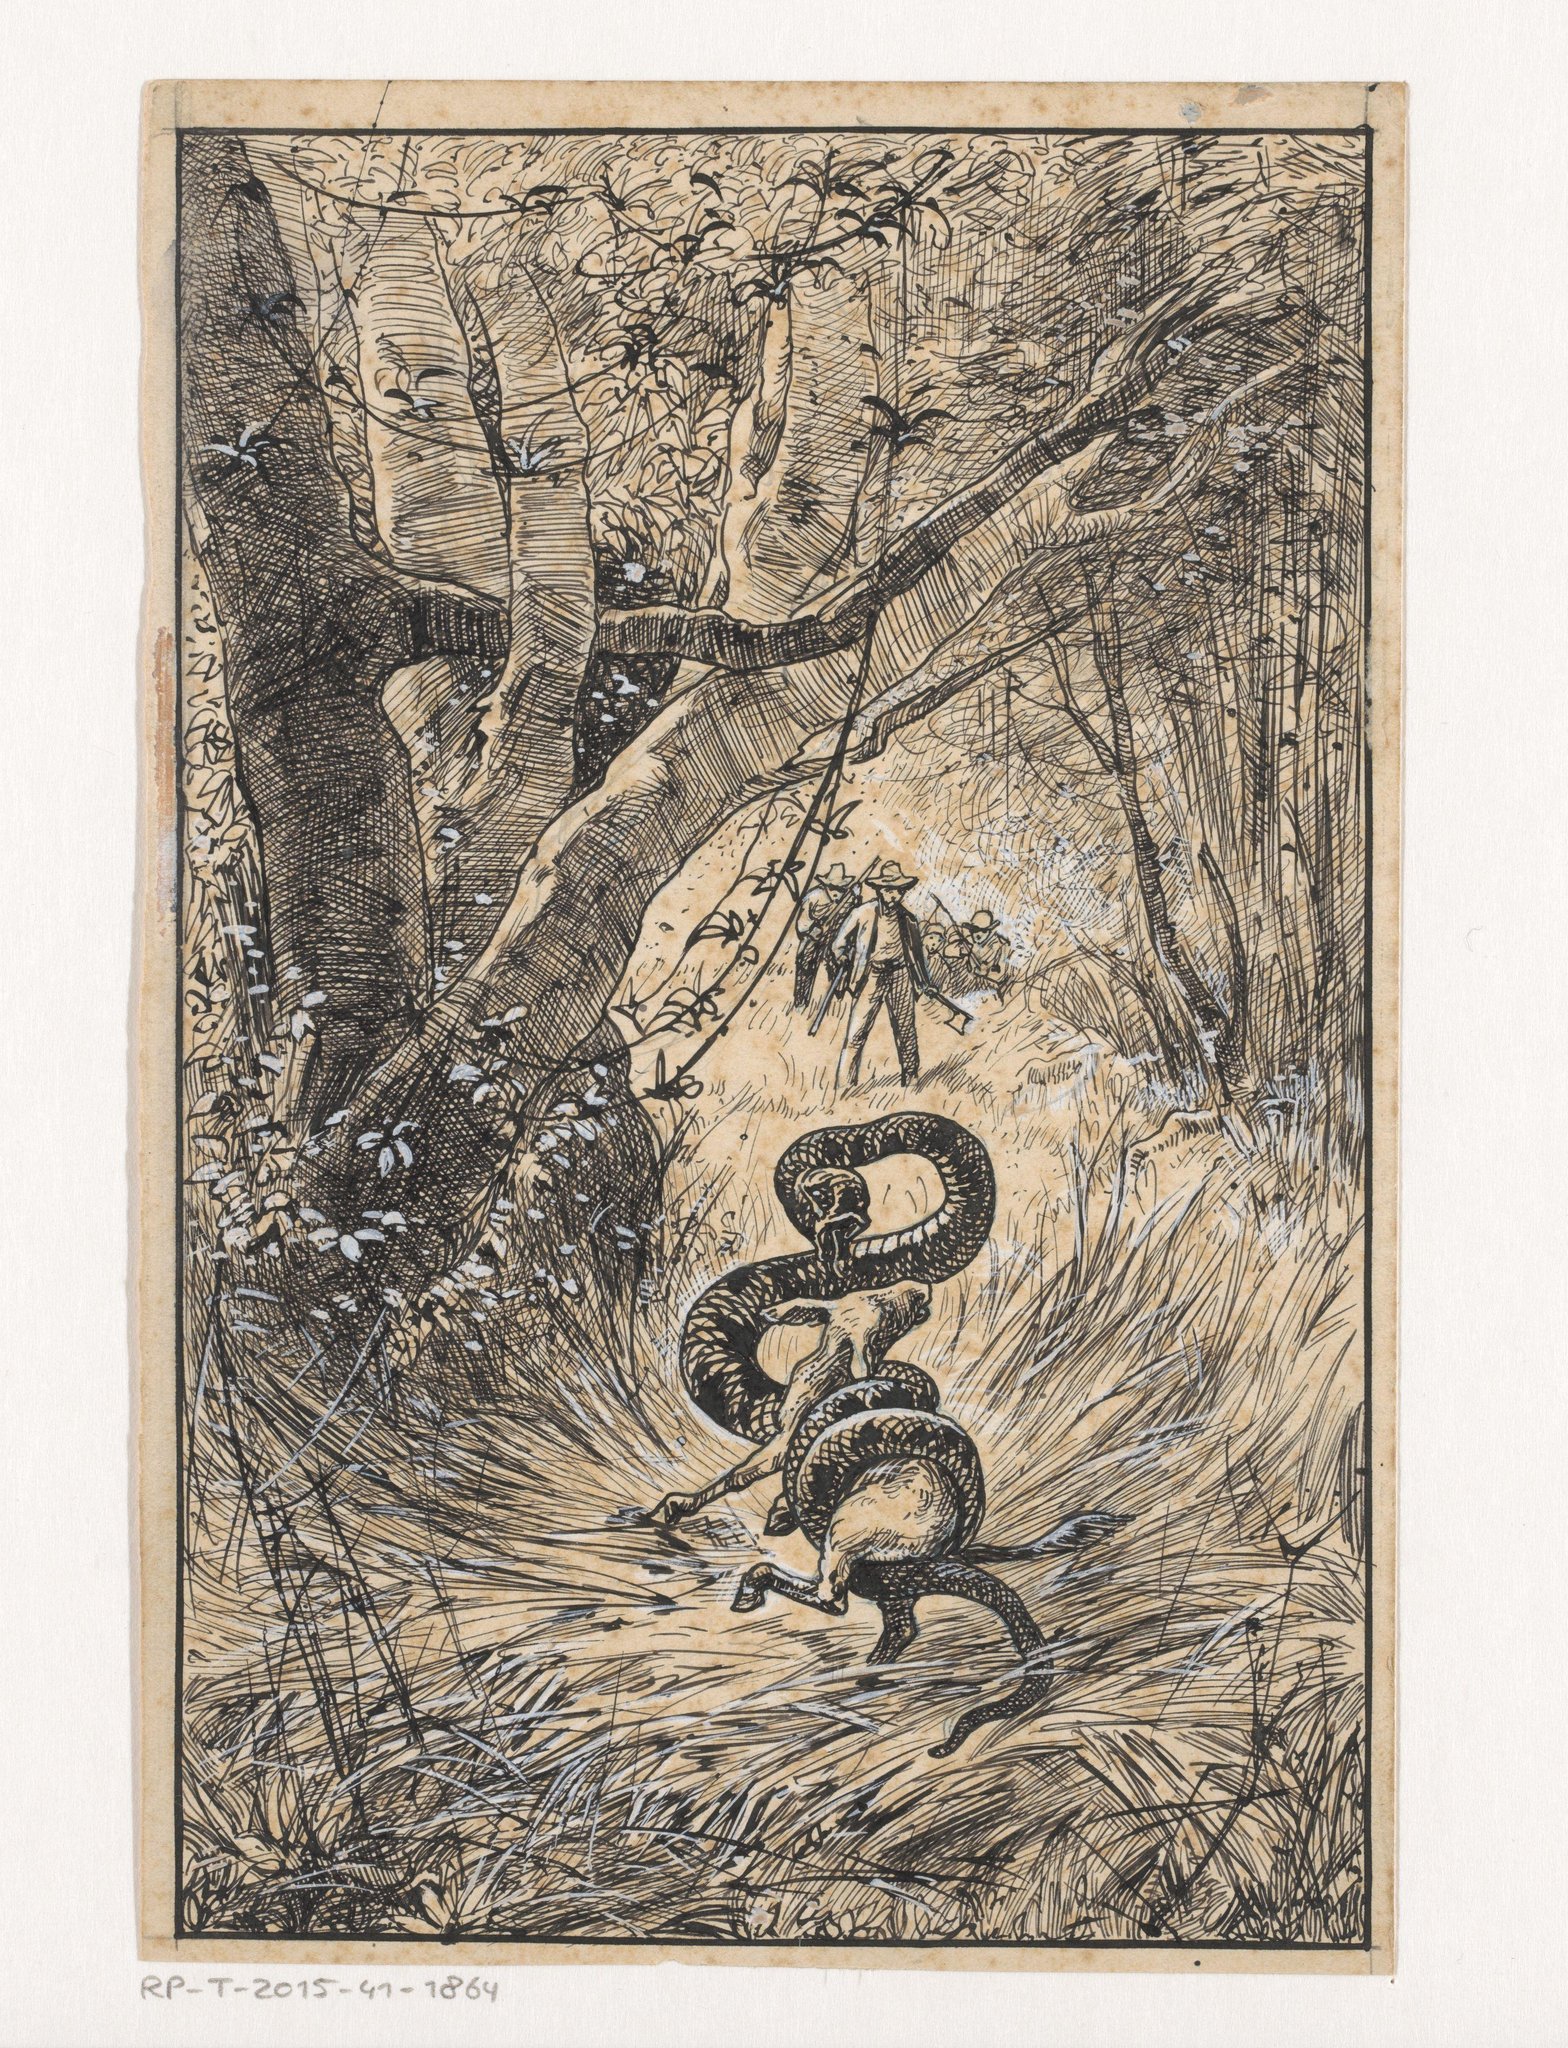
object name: boekillustratie ontwerp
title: Slang wurgt een geit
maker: willem wenckebach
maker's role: designer, draughtsman, painter, print maker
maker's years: 1860-1937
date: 1870-1937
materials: paint, ink, paper, pencil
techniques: brush, pen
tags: snakes, hunter, forest, wood, goat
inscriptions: collector's mark: Lugt 2228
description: Op een vlakte in een bos heeft een slang met opengesperde bek zich tweemaal rond het lichaam van een geit gekruld. In de achtergrond komt een gezelschap van jagers met hak- en vuurwapens aangelopen.